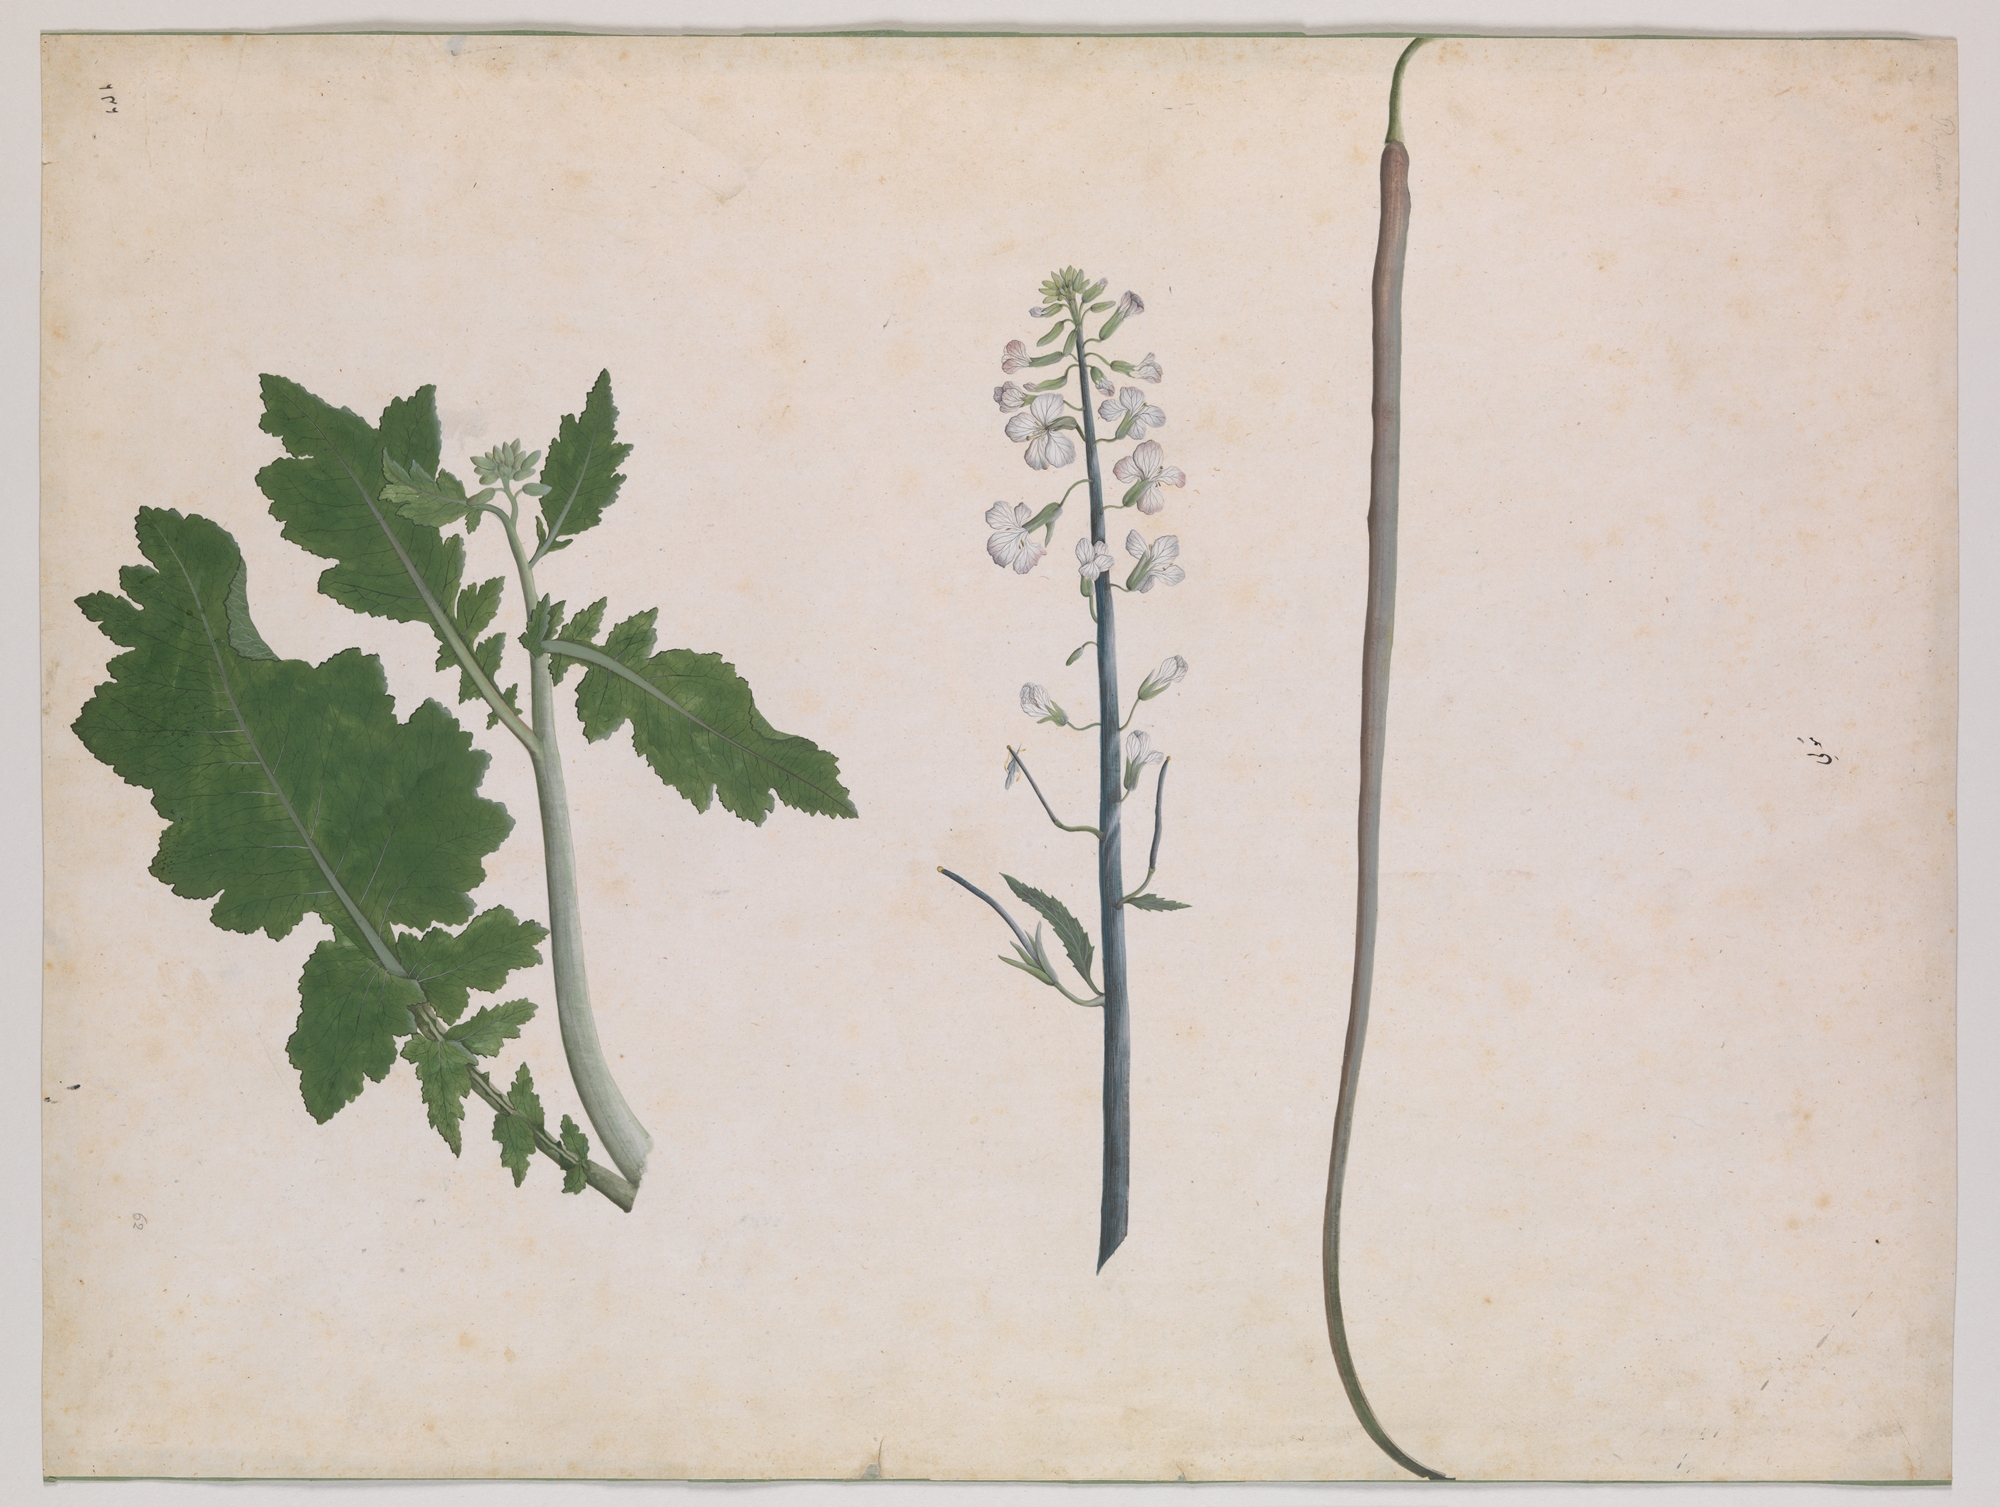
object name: illustrated single work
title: A Radish Plant, Seed, and Flower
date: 1767-1800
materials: ink, paper, watercolor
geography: india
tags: flowers,plants